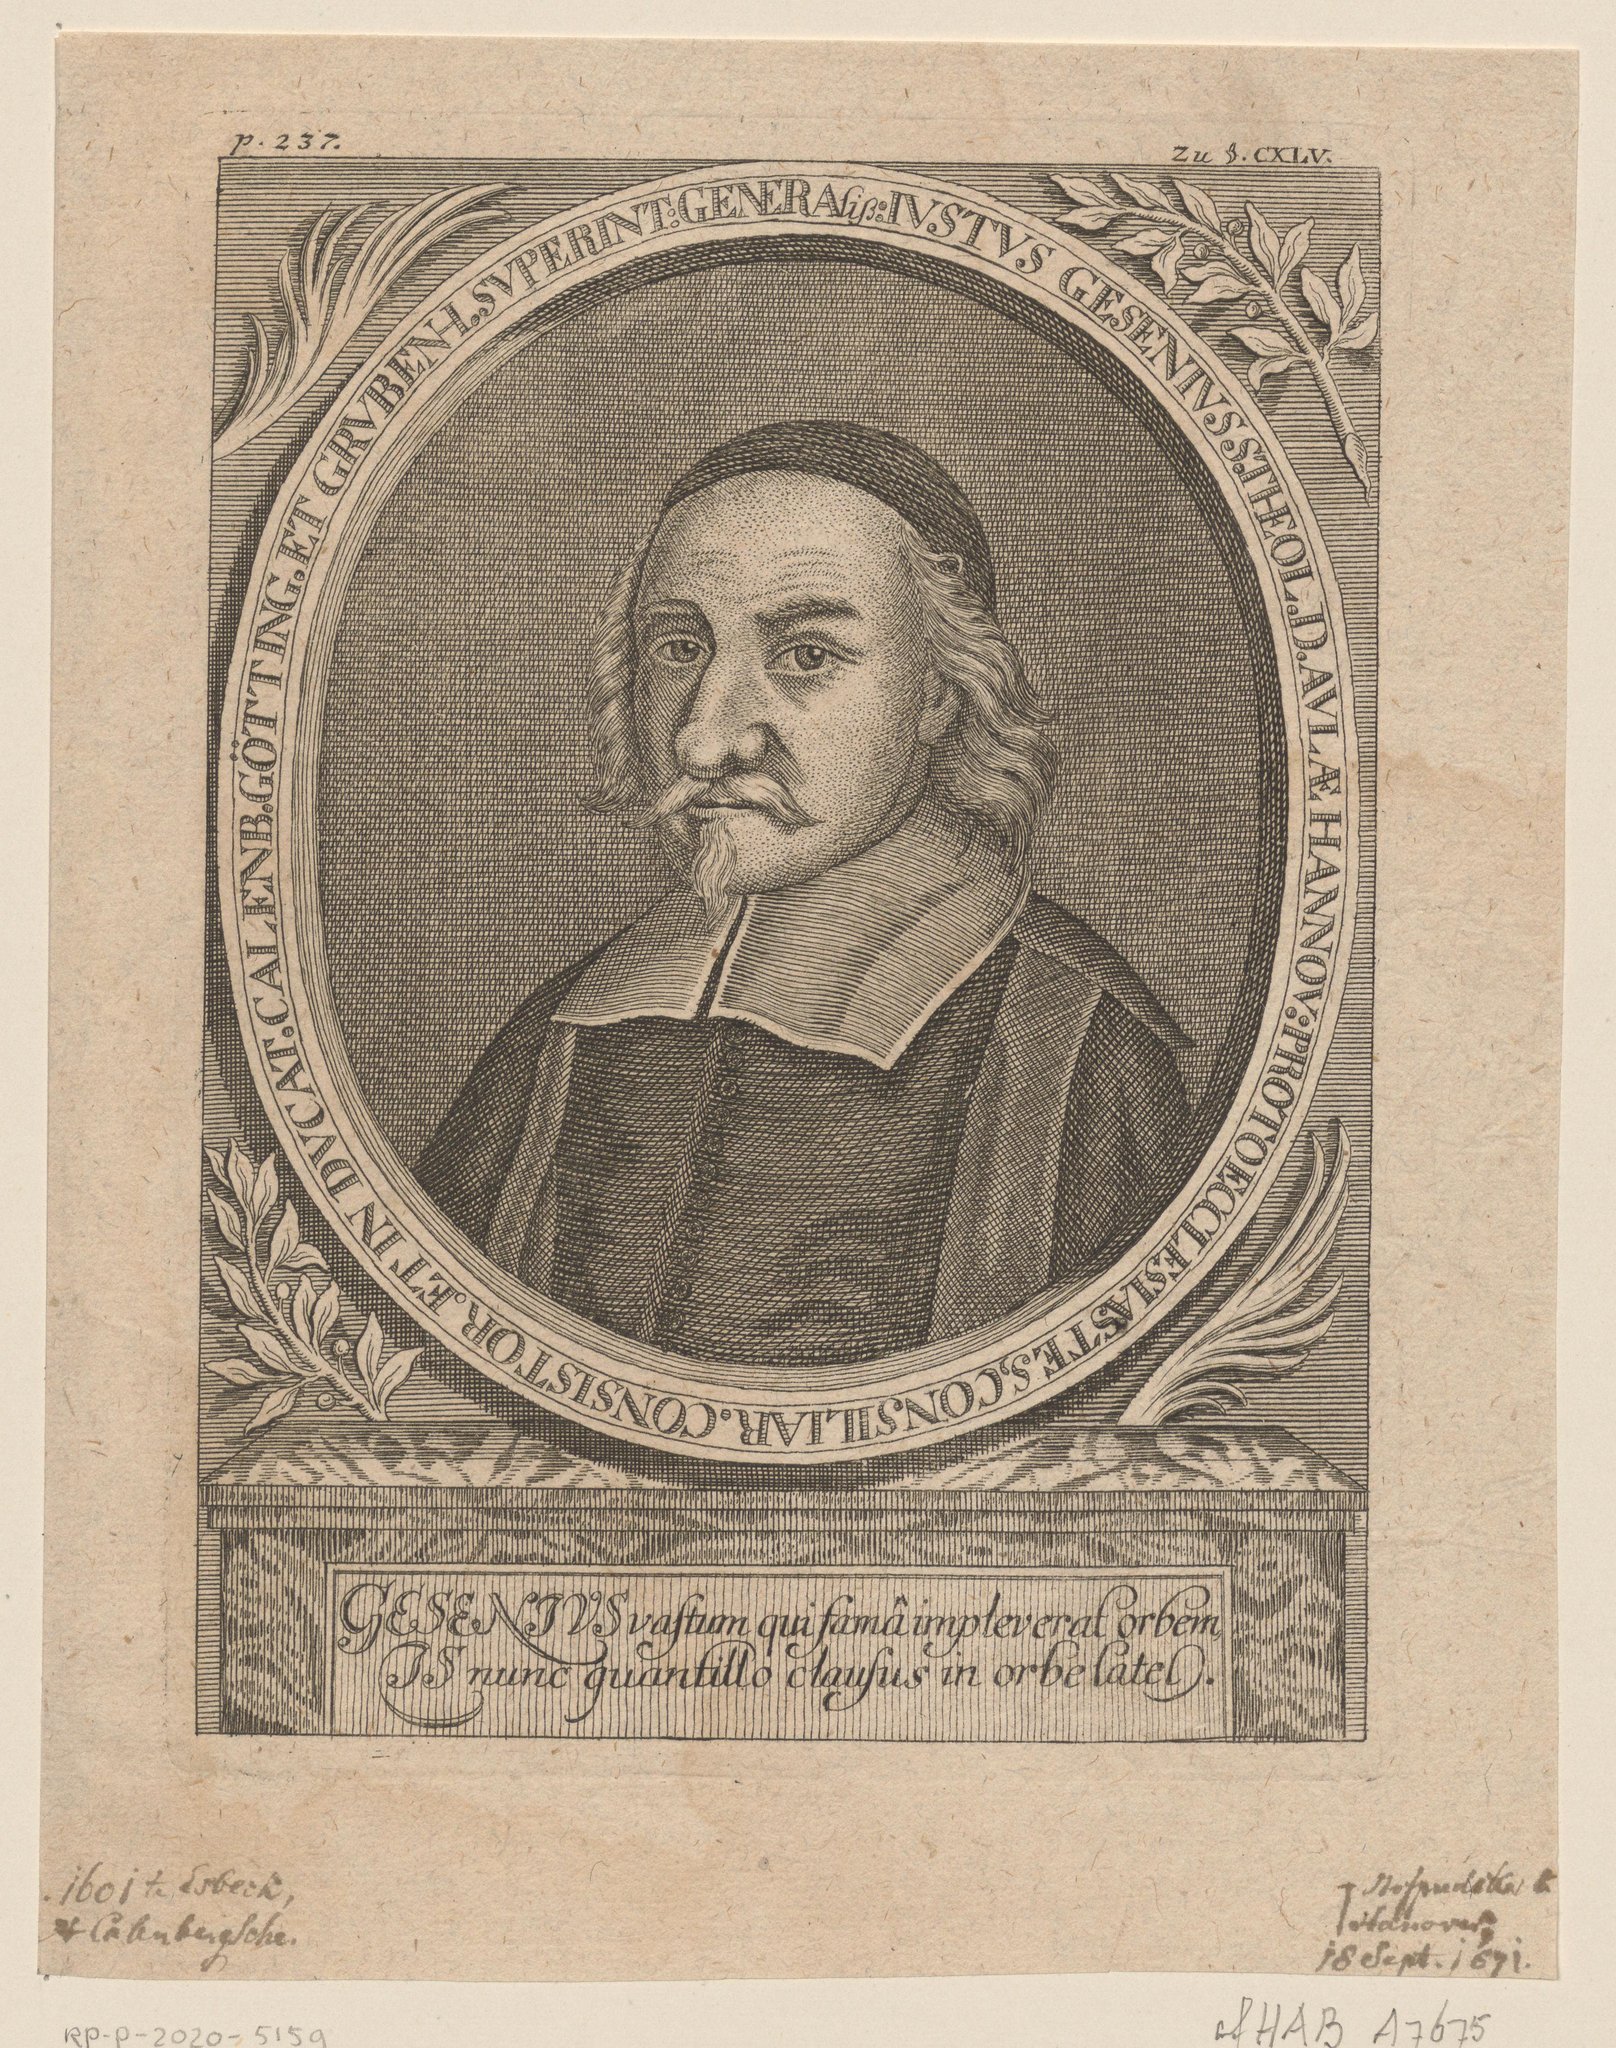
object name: book illustration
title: Portret van Justus Gesenius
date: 1744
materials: paper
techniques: engraving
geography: lemgo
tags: theologian, historical persons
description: Prent uit: Baringius, Daniel Eberhard. Descriptio salae principatus Calenbergici locorumque adjacentrium (...). Lemgo: Johann Heinrich Meyer, 1744, p. 237.